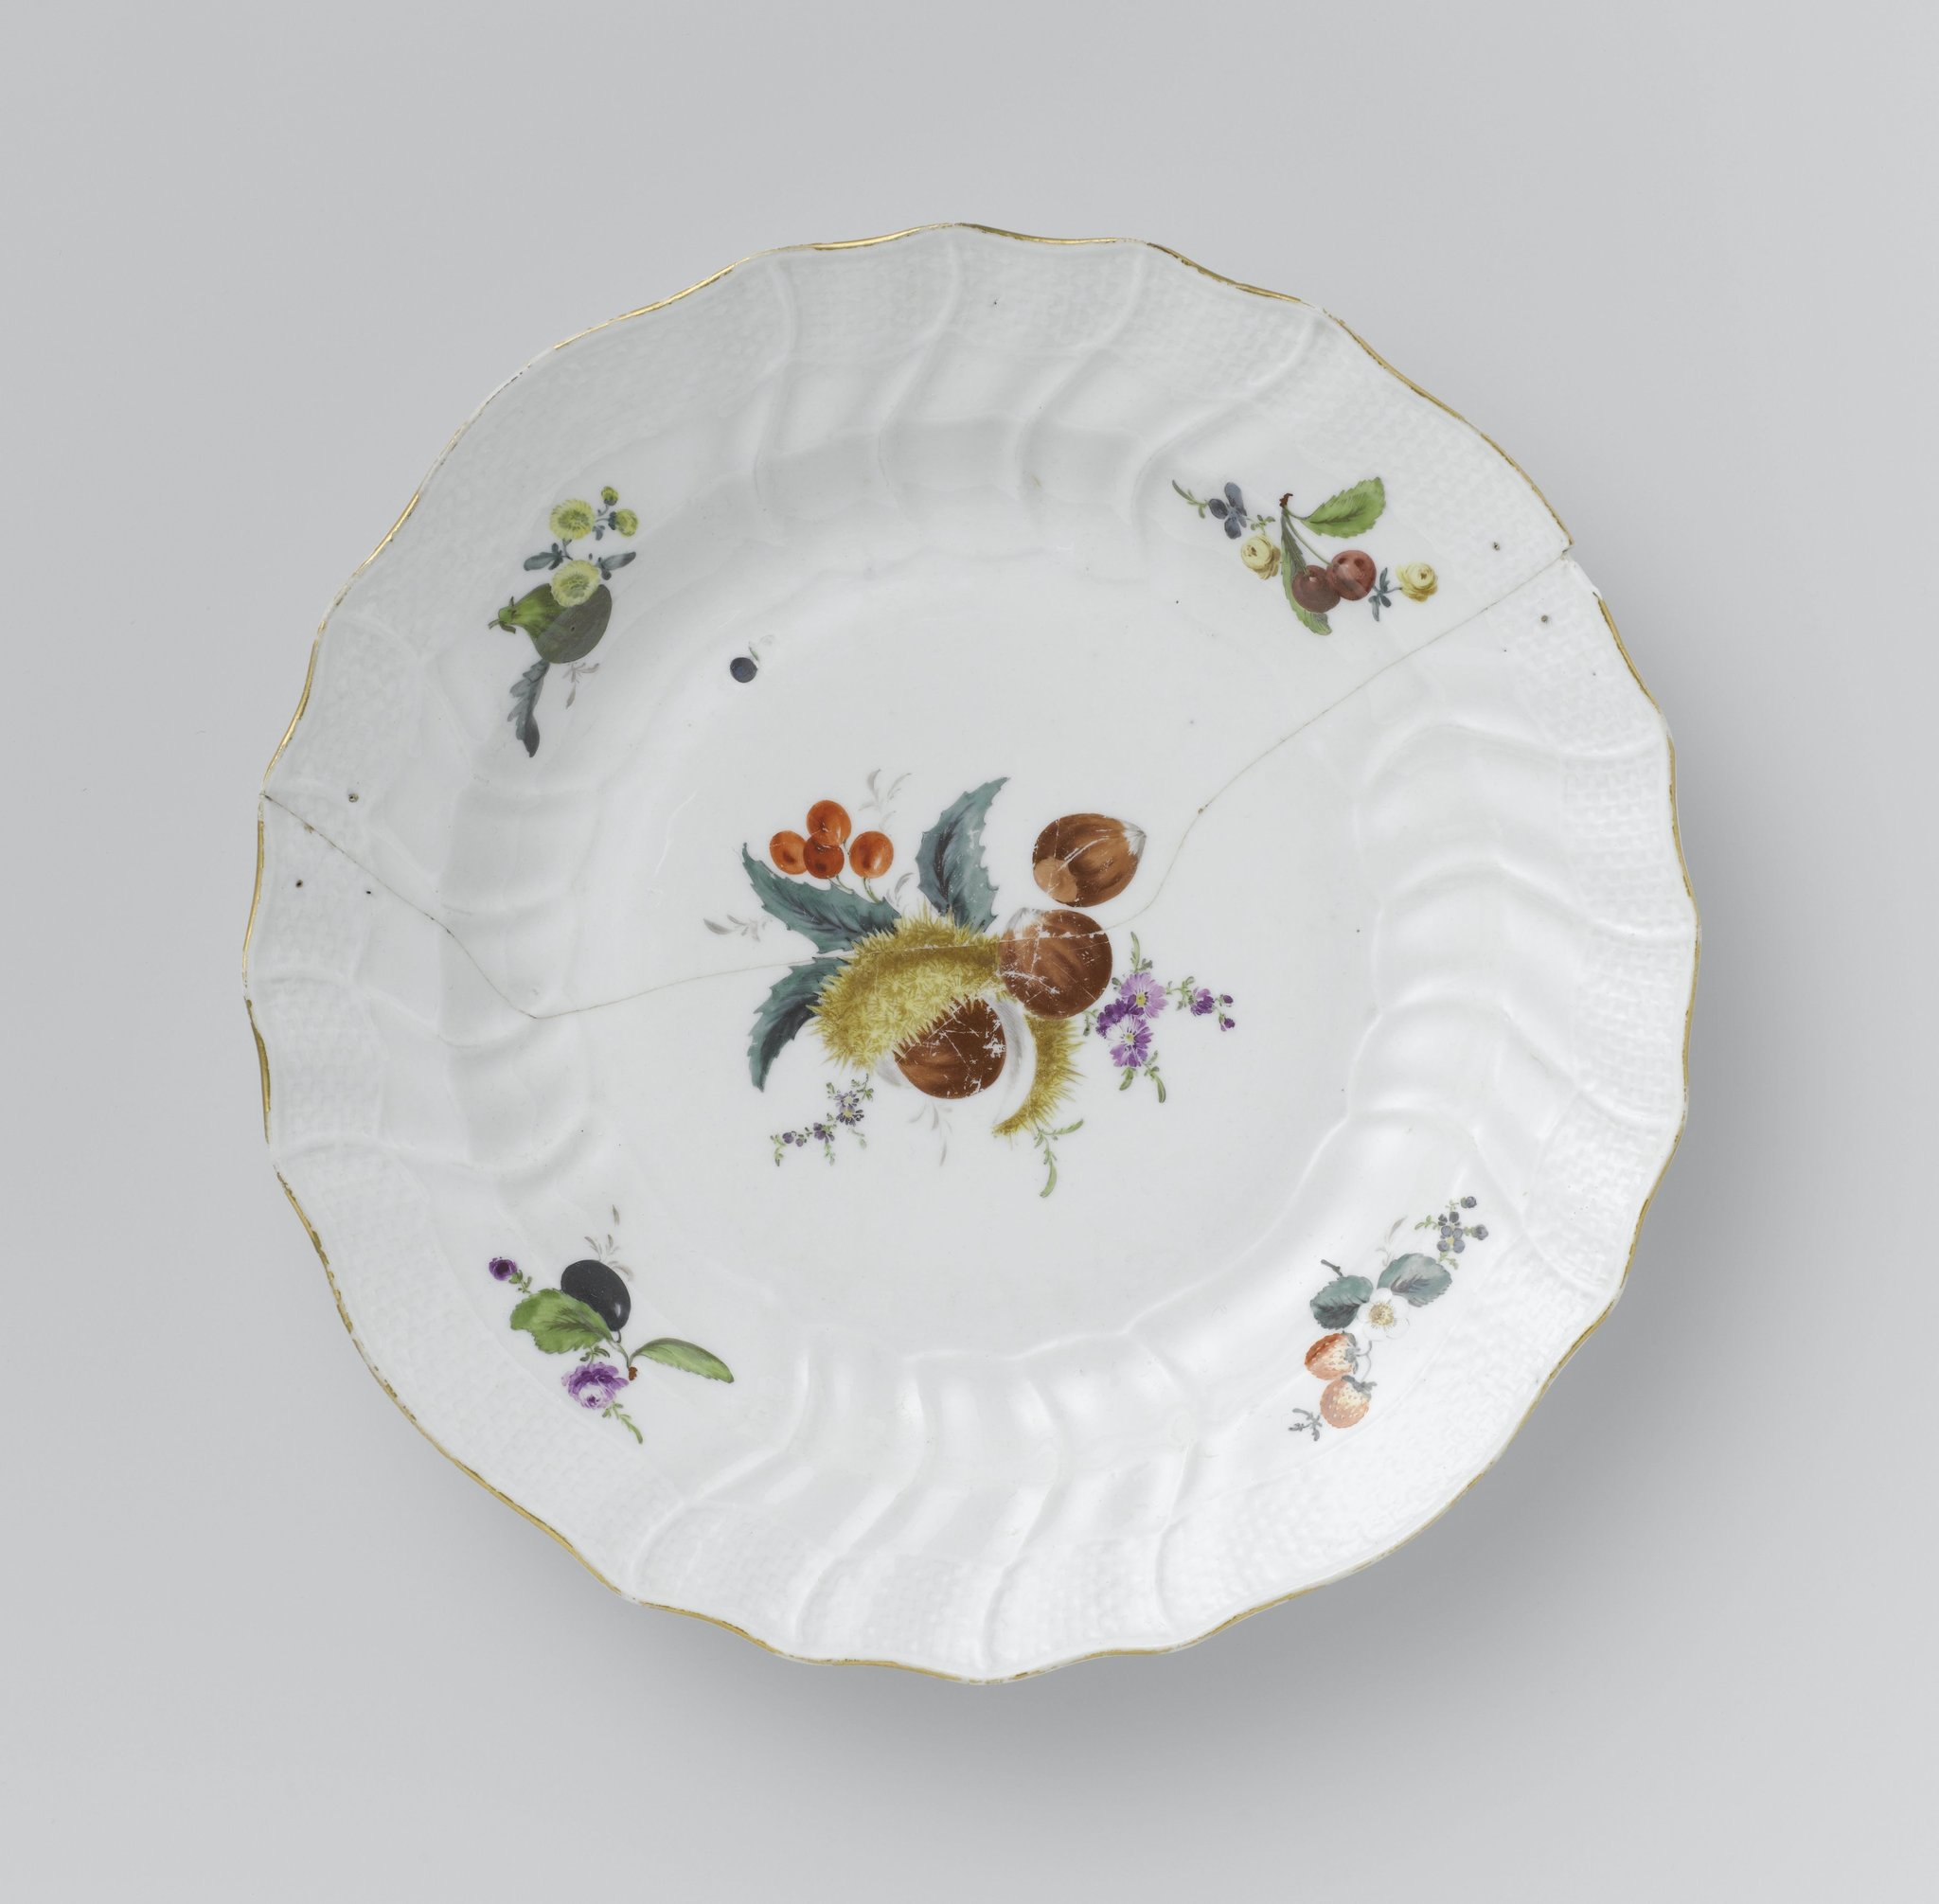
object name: plate dish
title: Bord, veelkleurig beschilderd met Deutsche Blumen, insekten en vruchten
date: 1750-1760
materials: porcelain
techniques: painted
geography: meissen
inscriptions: factory mark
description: Rond bord van beschilderd porselein. De rand is versierd met het Neuozier-patroon. De beschildering bestaat uit Deutsche Blumen, insekten en vruchten. Het bord is gemerkt en hoort bij een servies (BK-17474-1 t/m BK-17474-253).